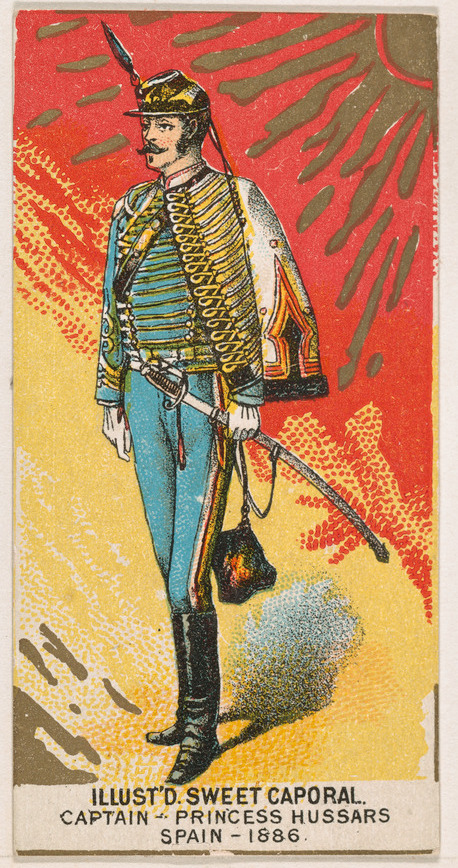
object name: print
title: Captain, Princess Hussars, Spain, 1886, from the Military Series (N224) issued by Kinney Tobacco Company to promote Sweet Caporal Cigarettes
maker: kinney brothers tobacco company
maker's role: publisher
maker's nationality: american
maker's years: 1869-2011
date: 1888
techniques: color lithograph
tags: soldiers,swords,men